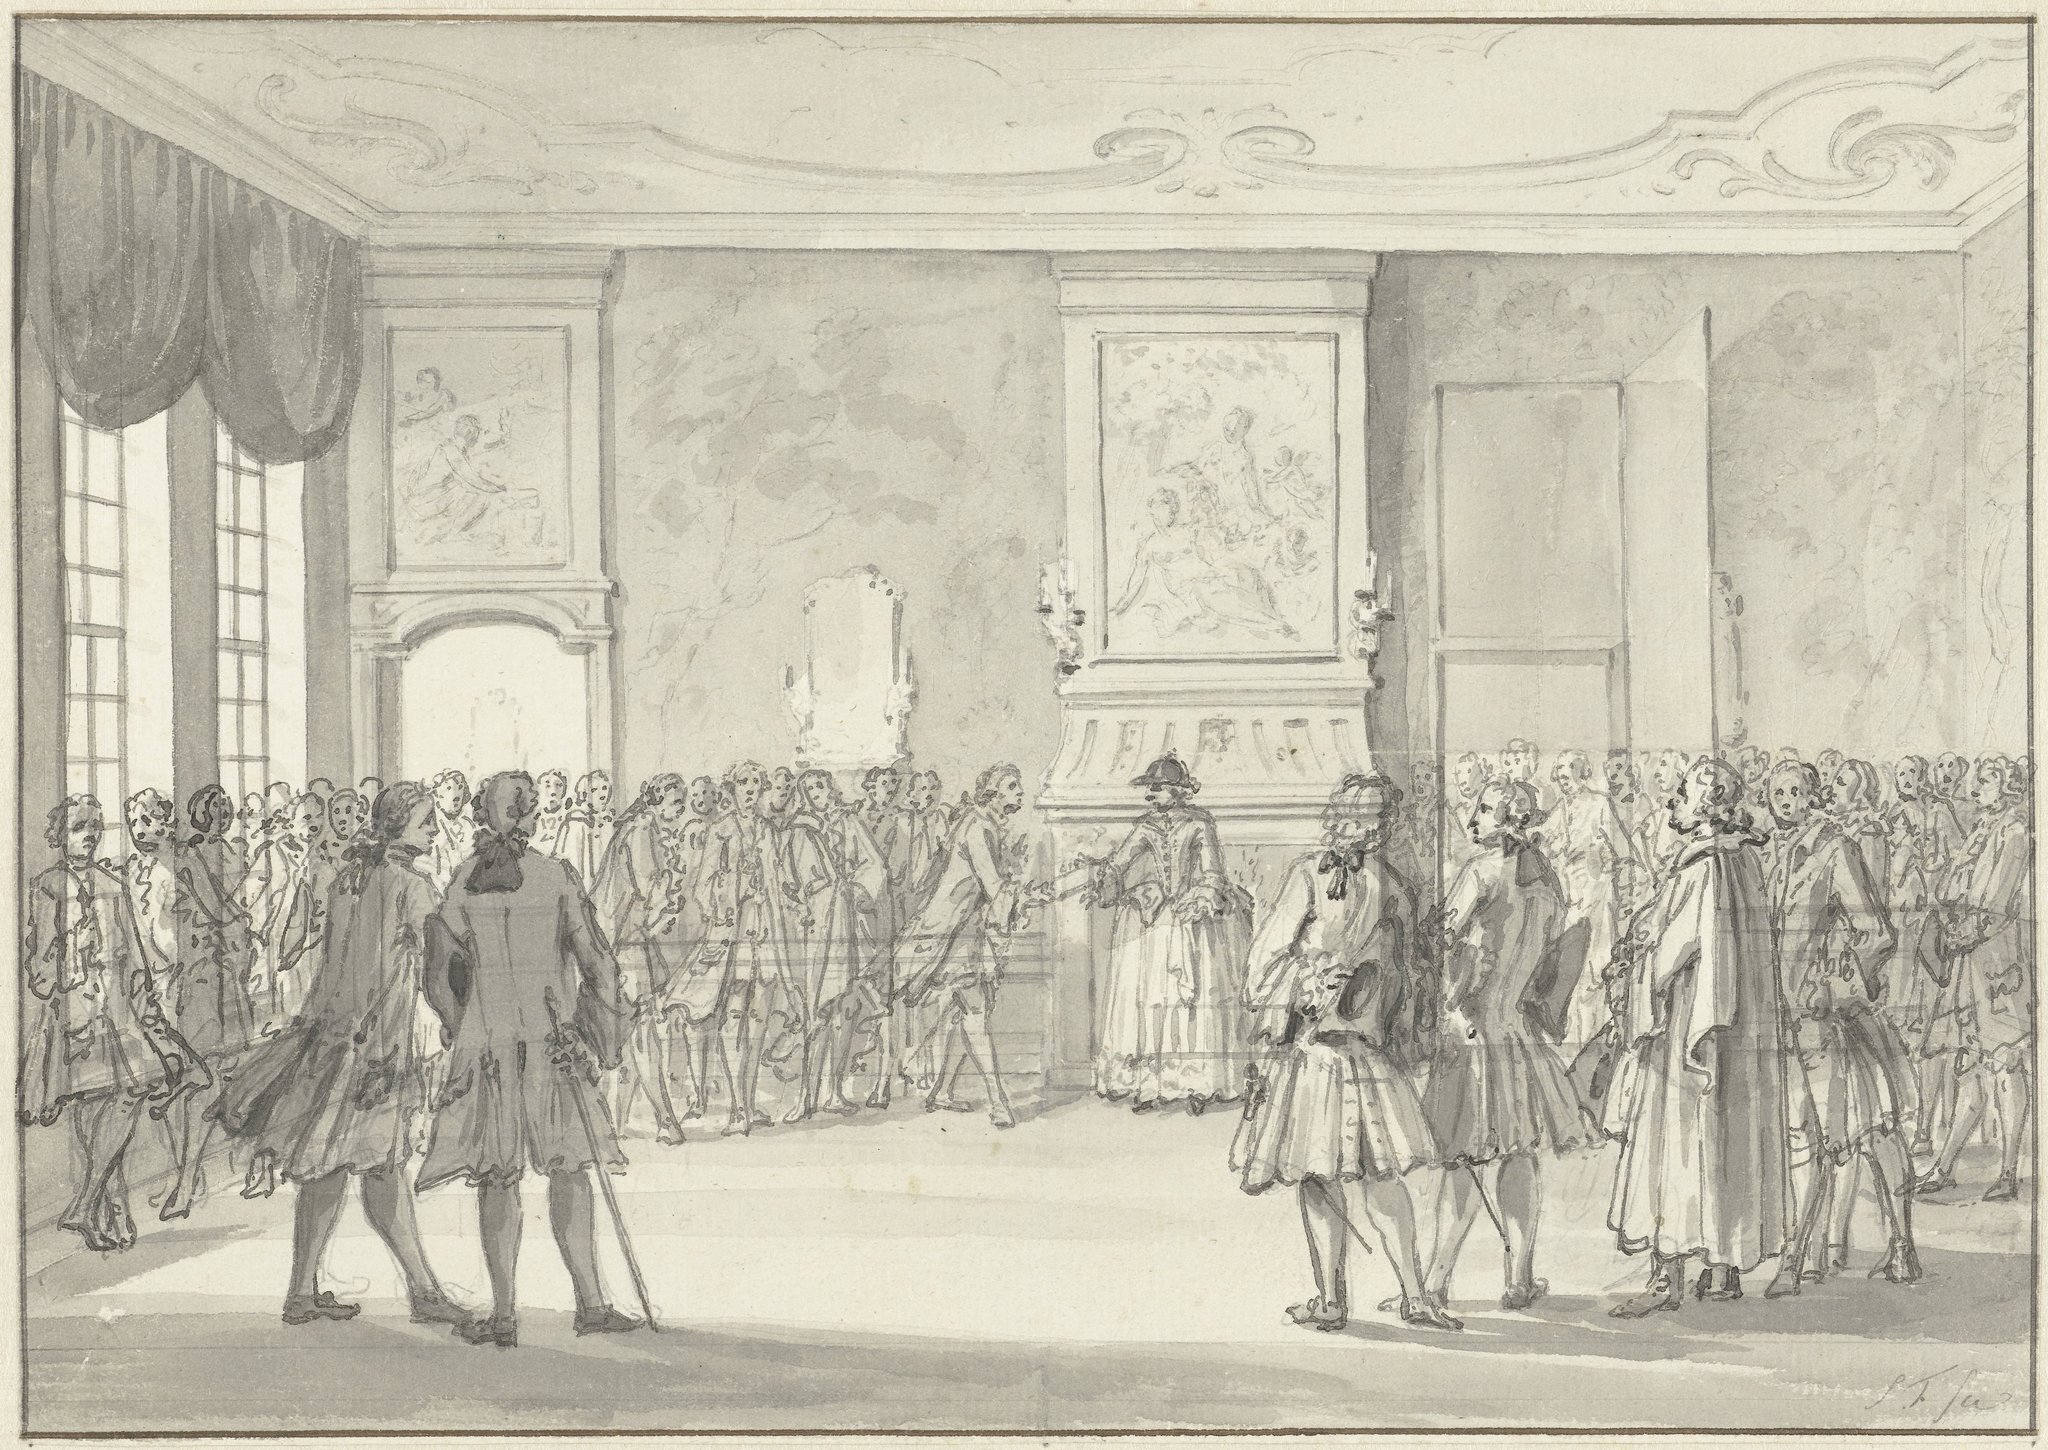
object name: drawing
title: Hollandse kooplieden overhandigen prinses Anna een klaagschrift over de Engelse aanvallen, 1758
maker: simon fokke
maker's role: draughtsman, print maker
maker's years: 1712-1784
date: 1758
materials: paper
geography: northern netherlands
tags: anna van hannover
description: Een delegatie van Hollandse kooplieden overhandigt aan de gouvernante (prinses Anna van Hannover) een klaagschrift over de Engelse aanvallen, 7 december 1758. Waarschijnlijk naar aanleiding van overvallen door de Engelsen op Nederlandse schepen in de Antillen. Ontwerp voor een prent.